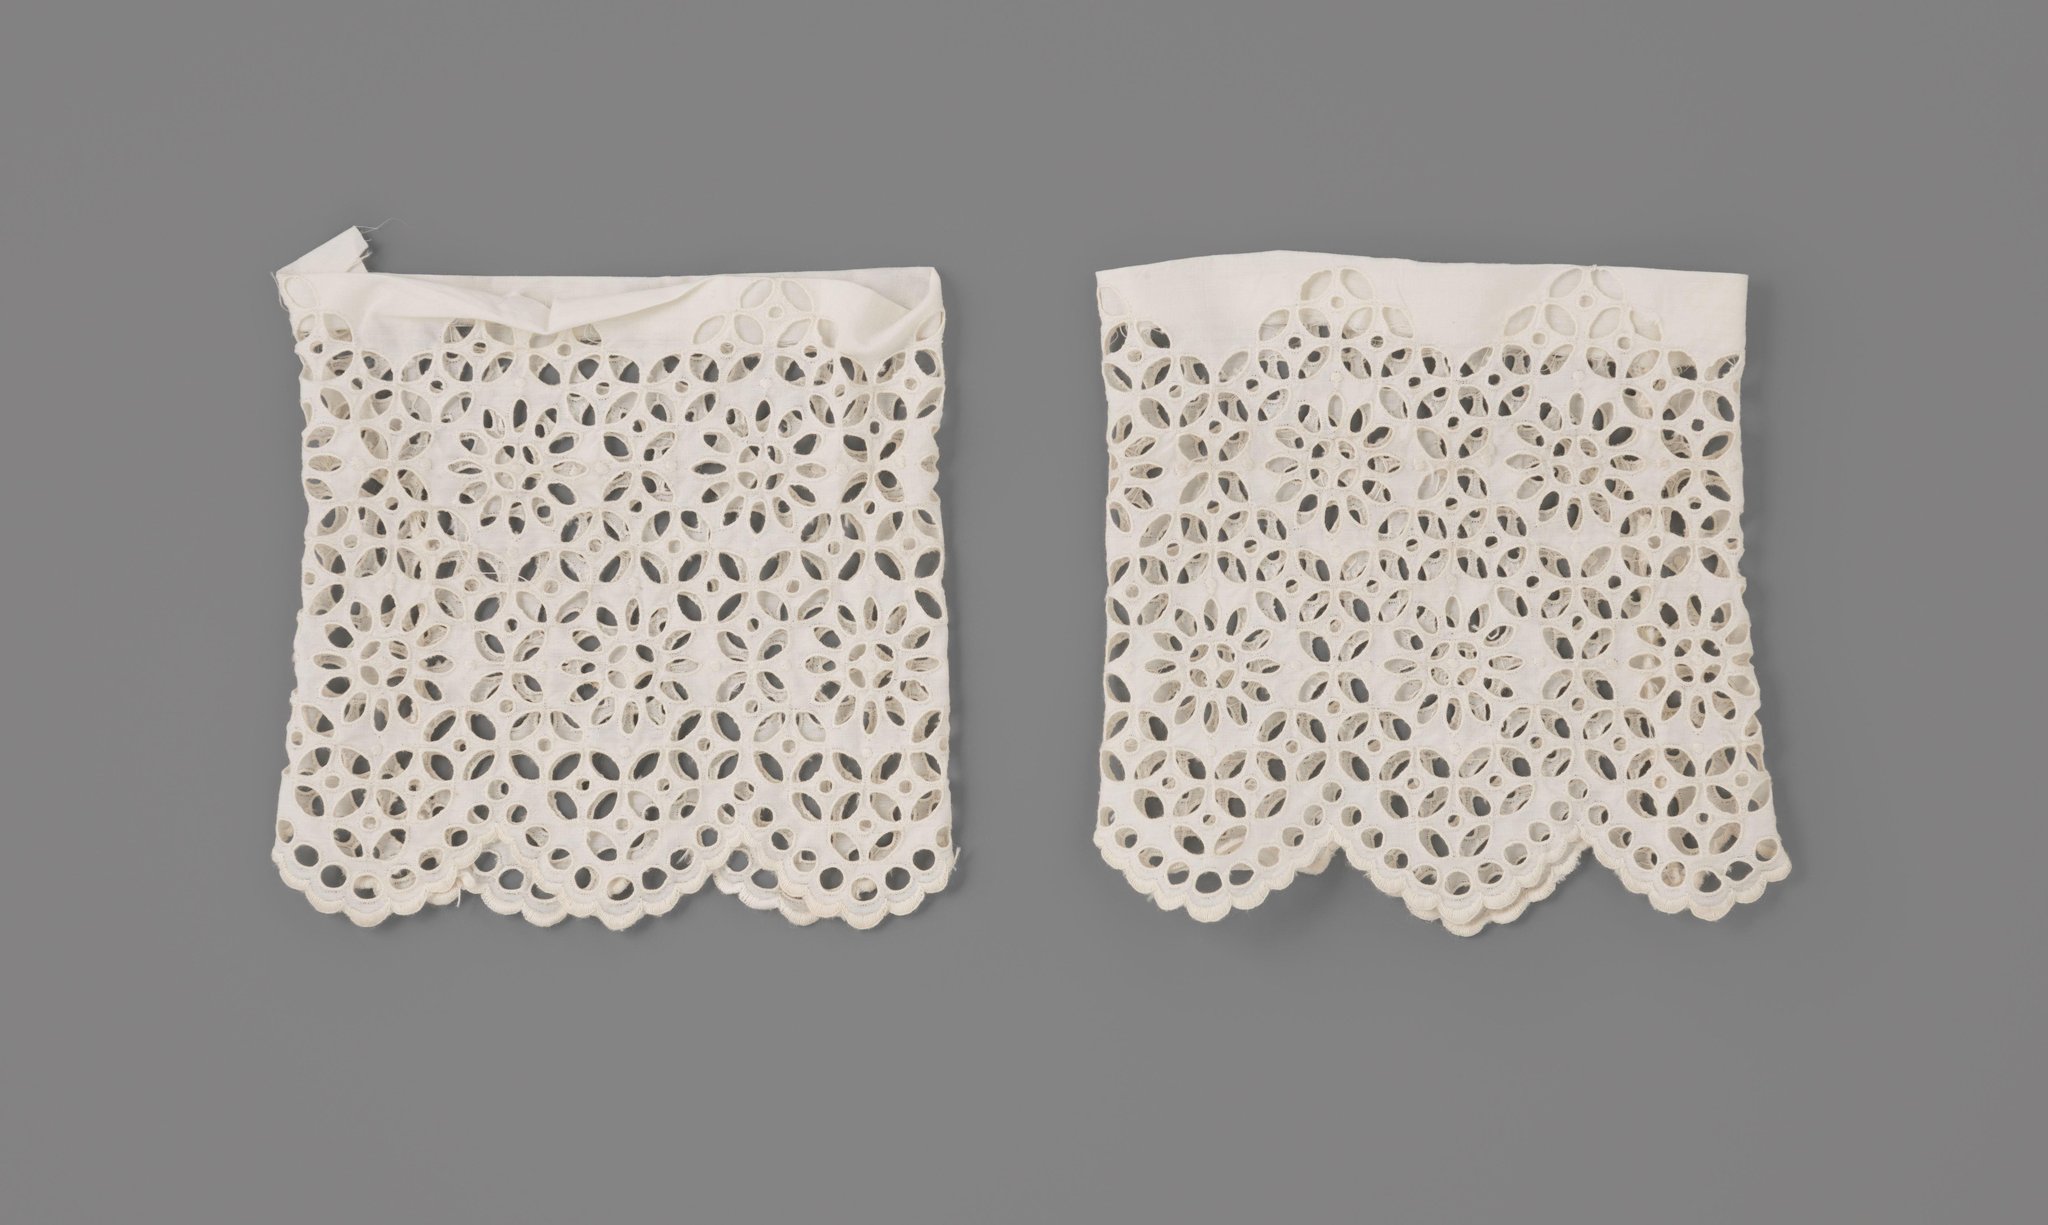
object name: cuff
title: Manchet van batist versierd met Engels borduurwerk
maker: Anonymous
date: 1875-1925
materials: textile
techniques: english embroidery, festoon stitch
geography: western europe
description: Manchet van batist versierd met Engels borduurwerk. De manchet is afgezet met een gefestonneerde schulprand.